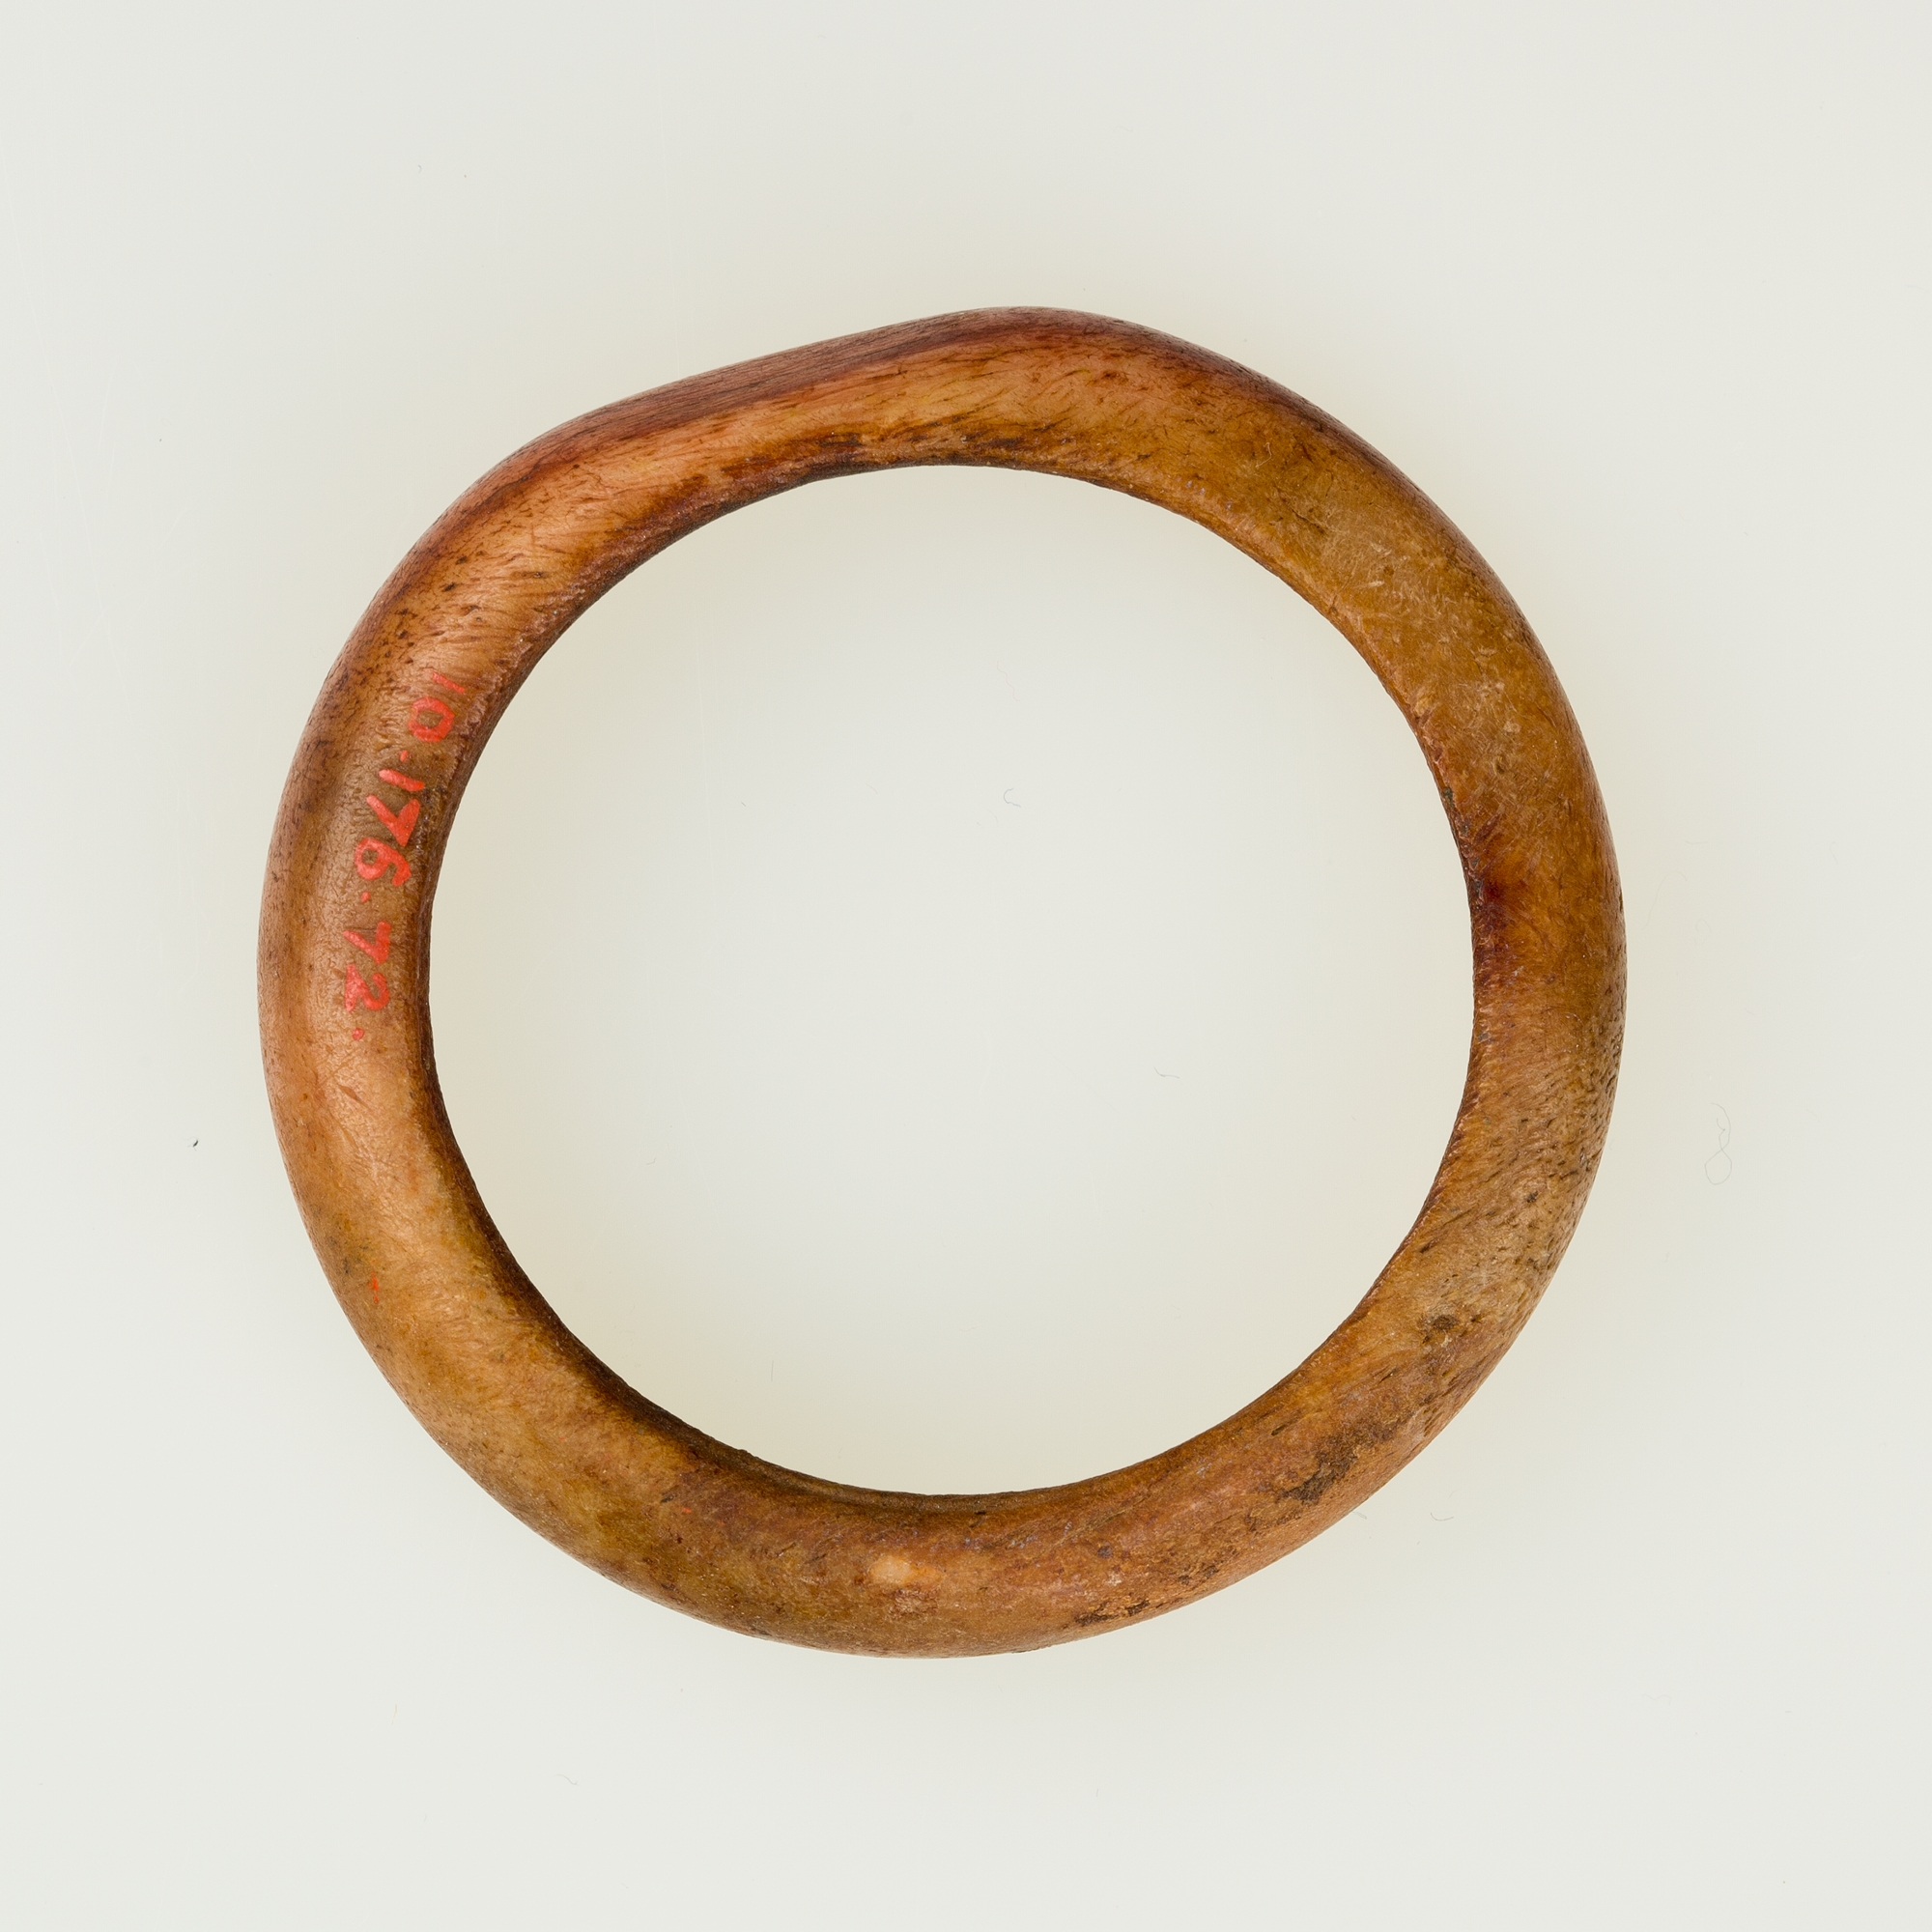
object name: bracelet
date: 3850-2960 BCE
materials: bone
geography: egypt